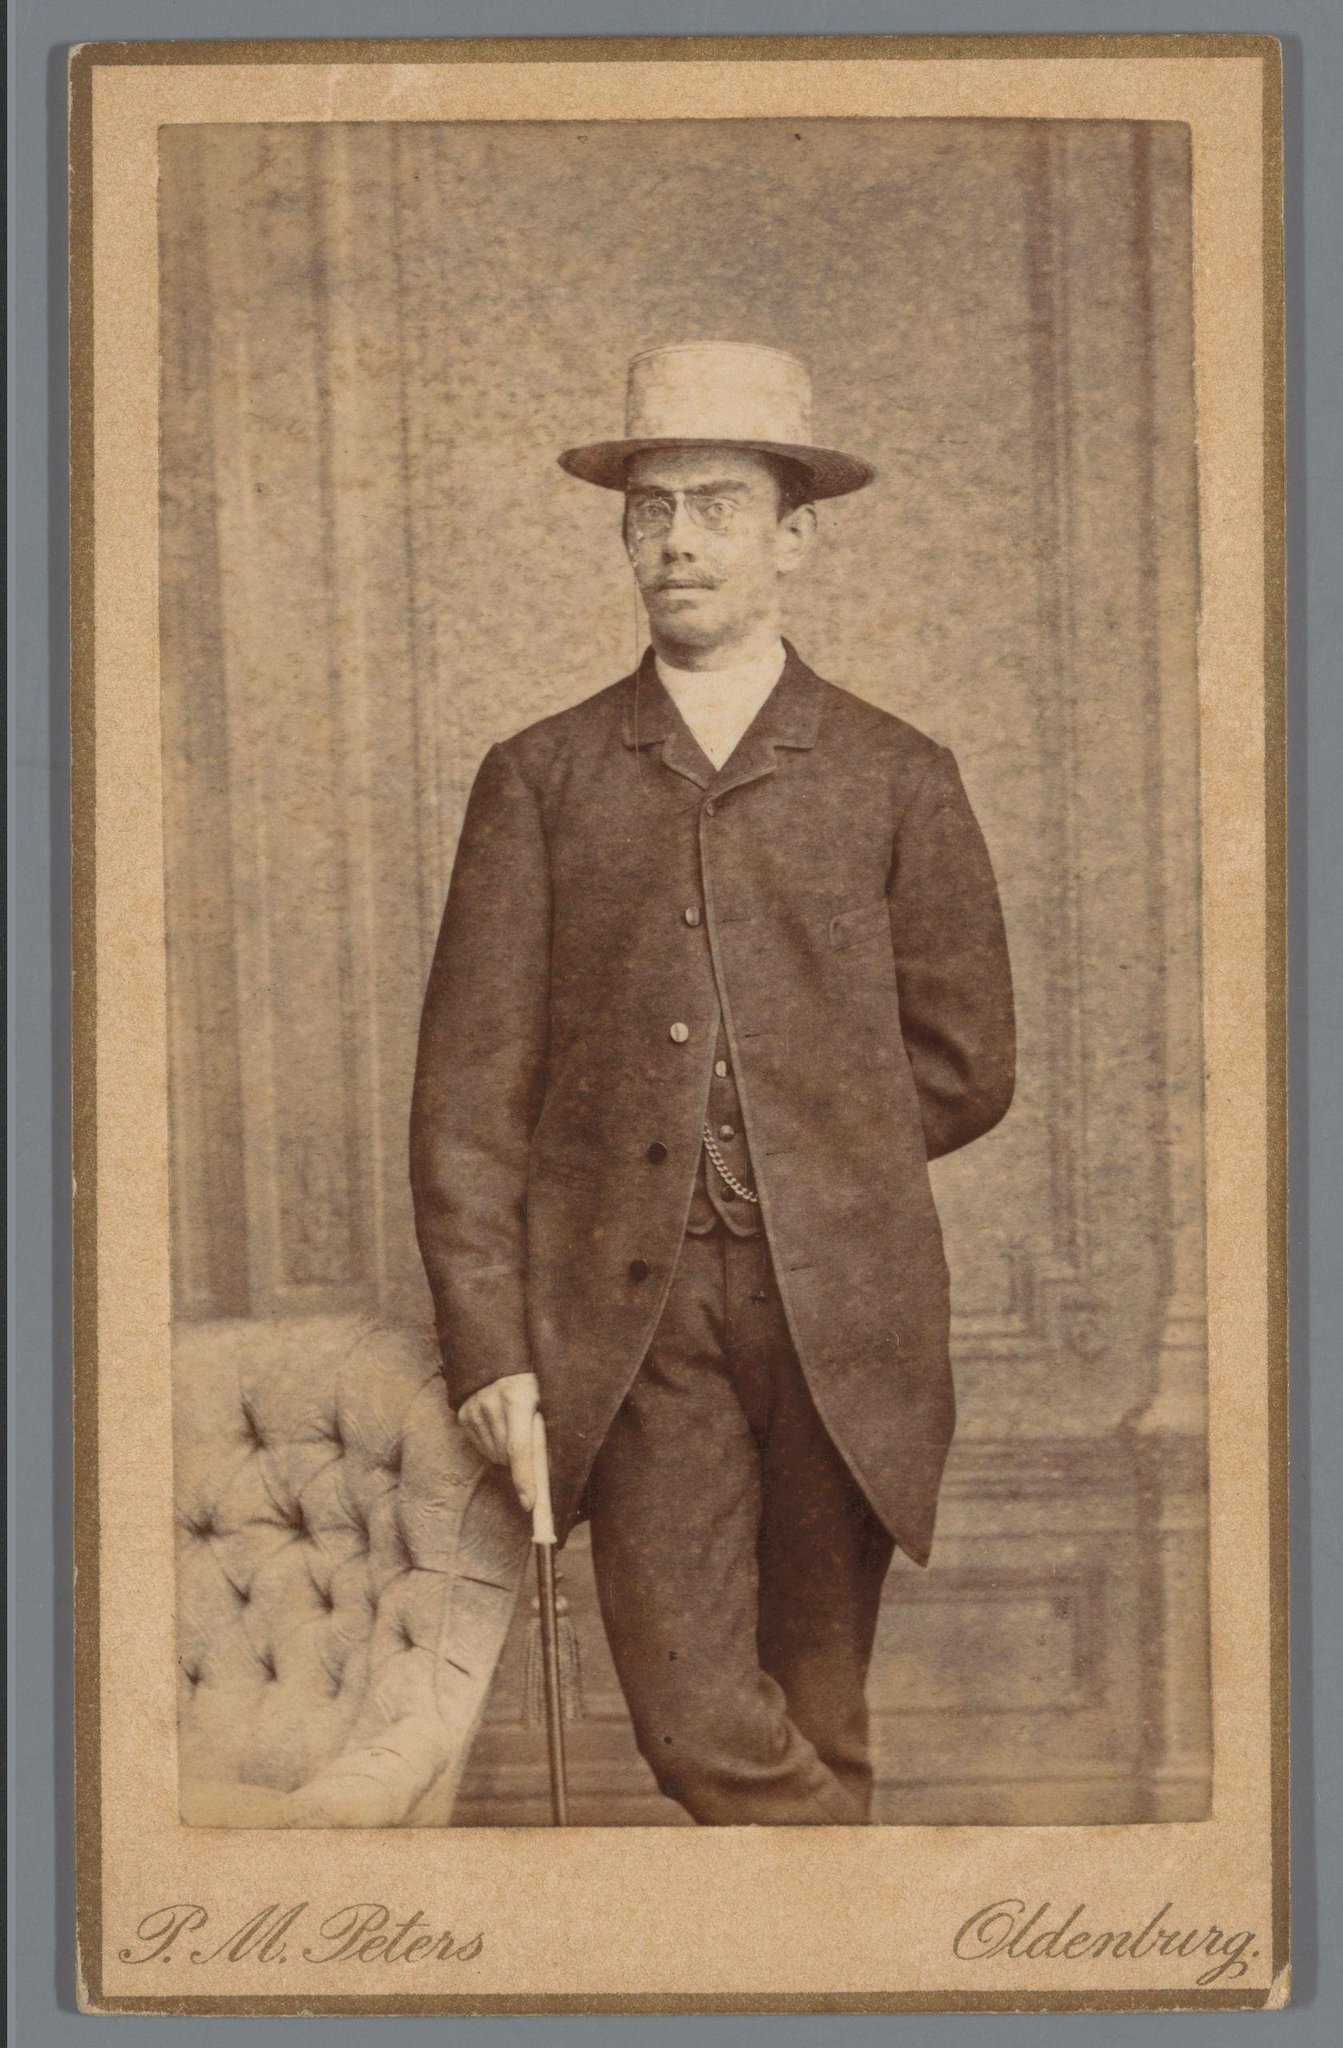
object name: carte de visite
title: Portret van J. Janssen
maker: p.m. peters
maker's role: fotograaf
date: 1887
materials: cardboard, paper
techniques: albumen print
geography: oldenburg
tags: adult man, historical persons, lawyer, attorney at law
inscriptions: inscription: ‘P.M. Peters/ Photogr. Atelier./ Oldenburg/ Innerer Damm No. 12,/ gegenüber dem Schlosse./ Die Platte bleibt für Nachbestellungen aufbewahrt.’, inscription: ‘(Advocaat in Duitsland)’, monogram: ‘PMP’, inscription: ‘P.M. Peters Oldenburg.’, inscription: ‘17.7.87 J. Janssen’